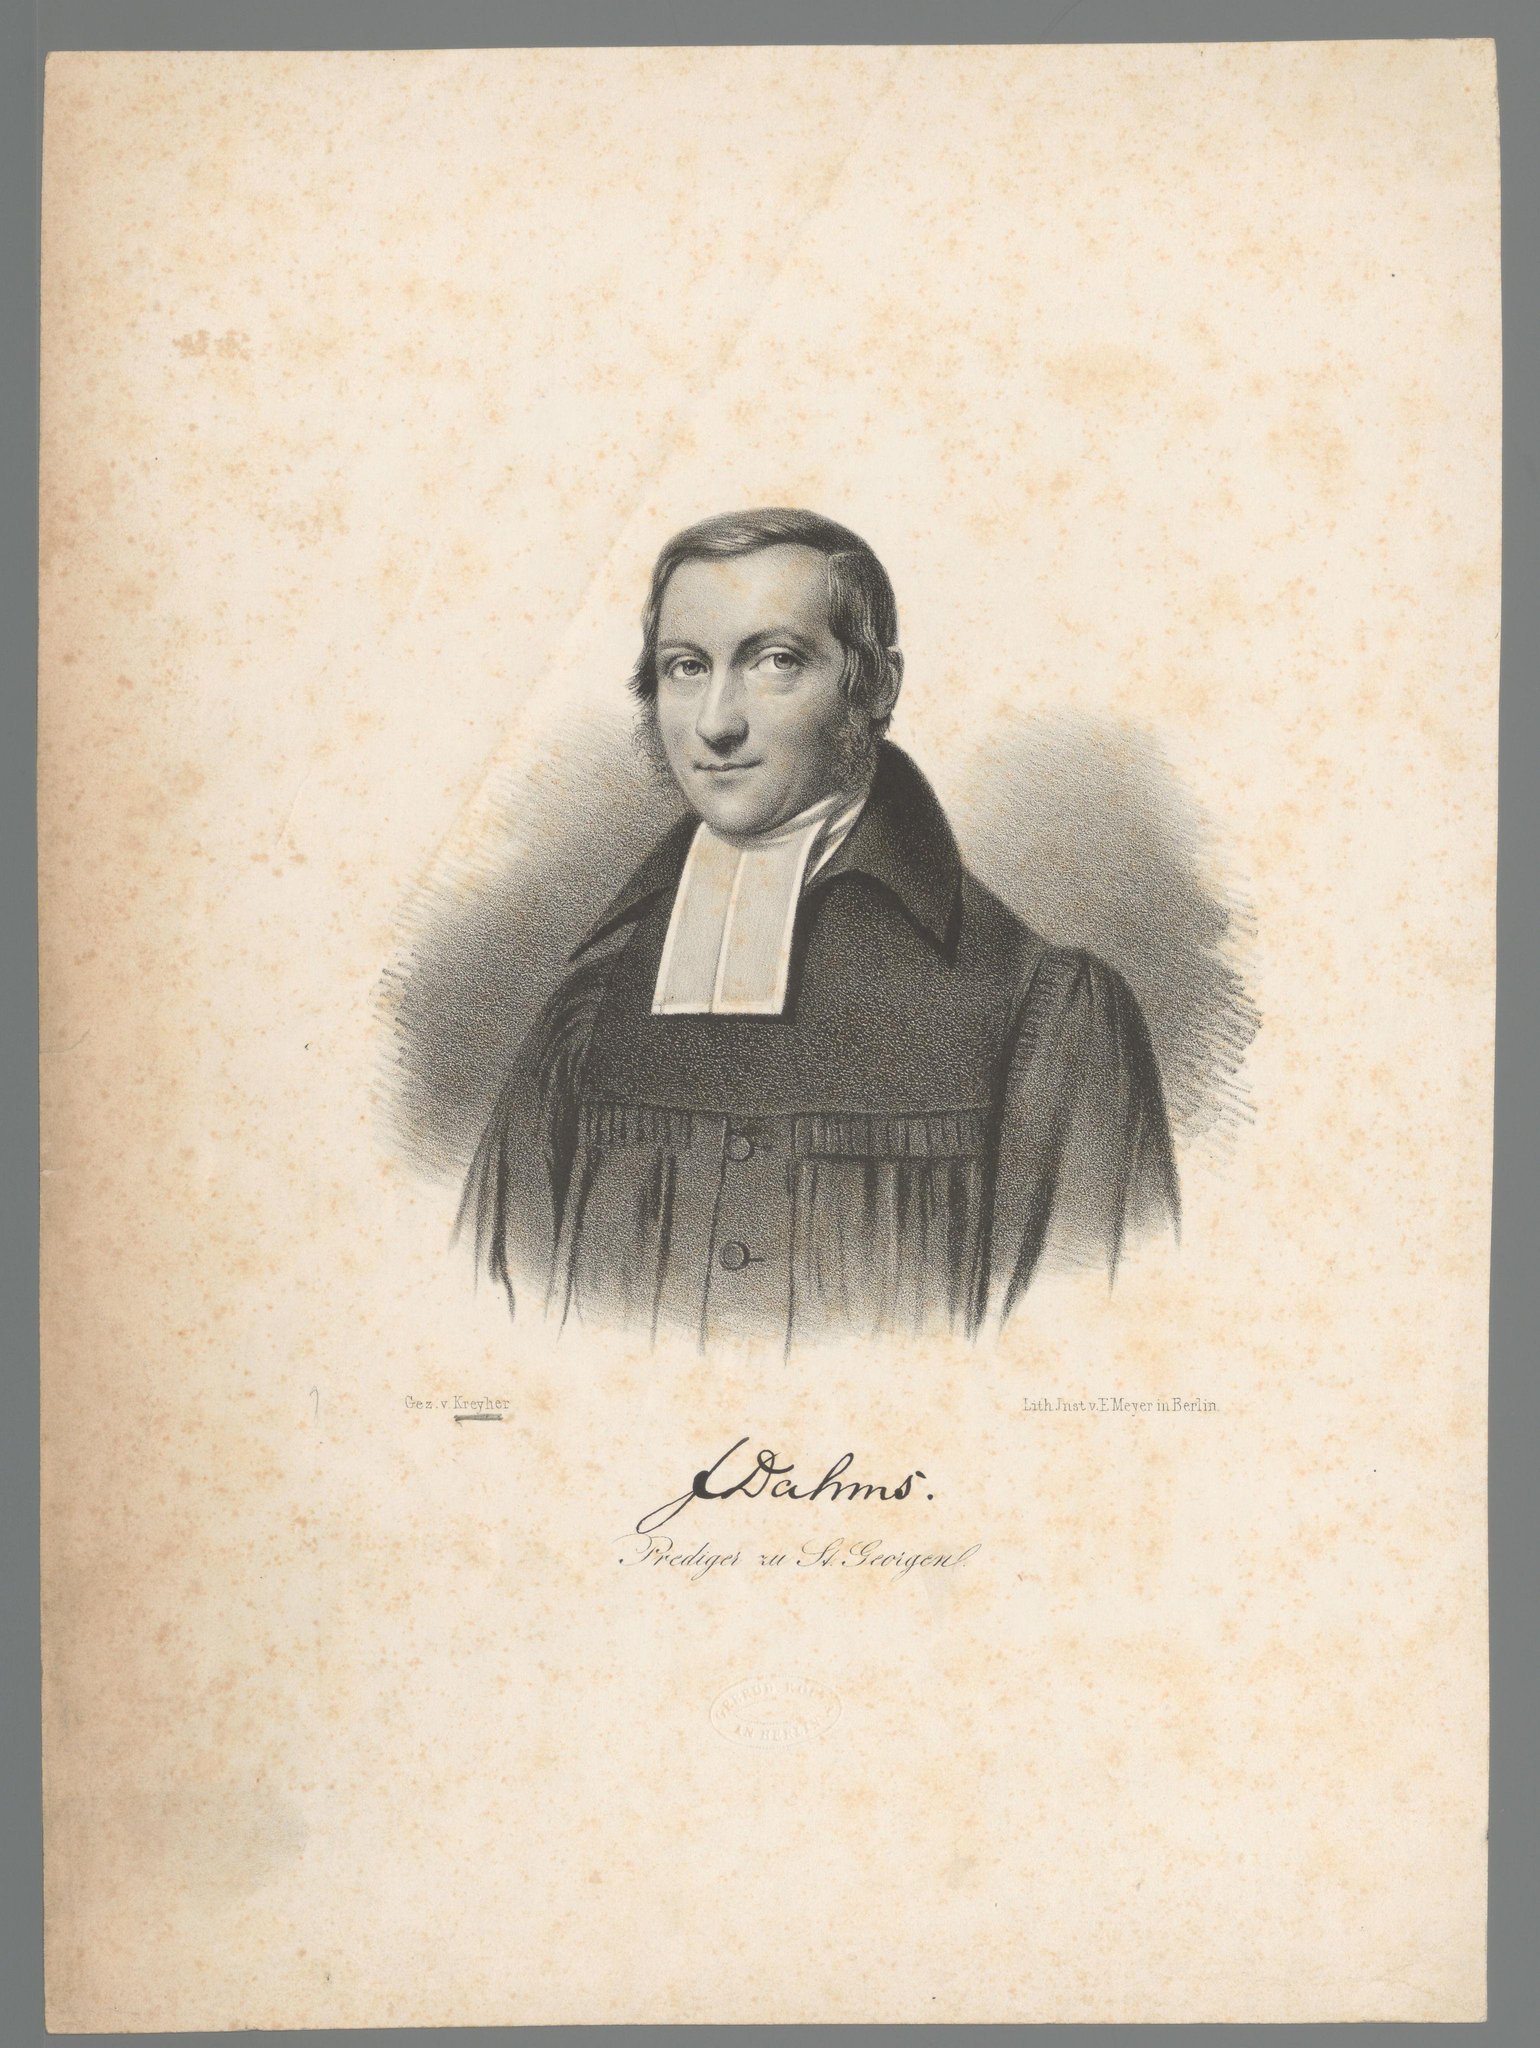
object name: print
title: Prediger zu St. Georgen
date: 1846-1905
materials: paper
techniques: lithograph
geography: berlin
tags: historical persons, functionaries and dignitaries ~ protestant churches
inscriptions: check stamp: Lugt 2141c, collector's mark: Lugt 2228